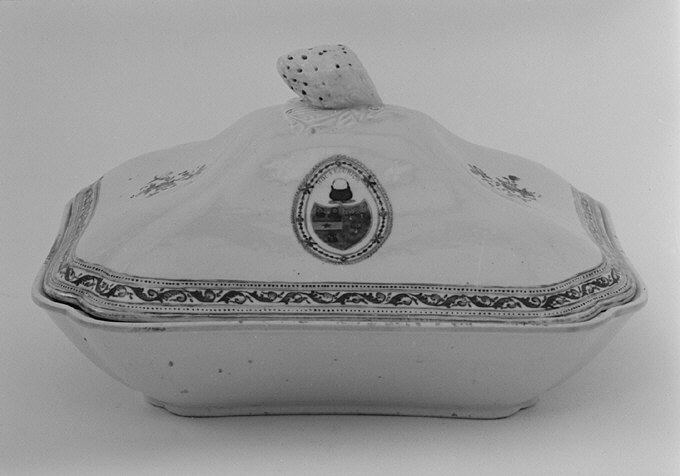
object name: vegetable dish with cover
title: Vegetable dish with cover (part of a service)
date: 1770-1785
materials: hard paste porcelain